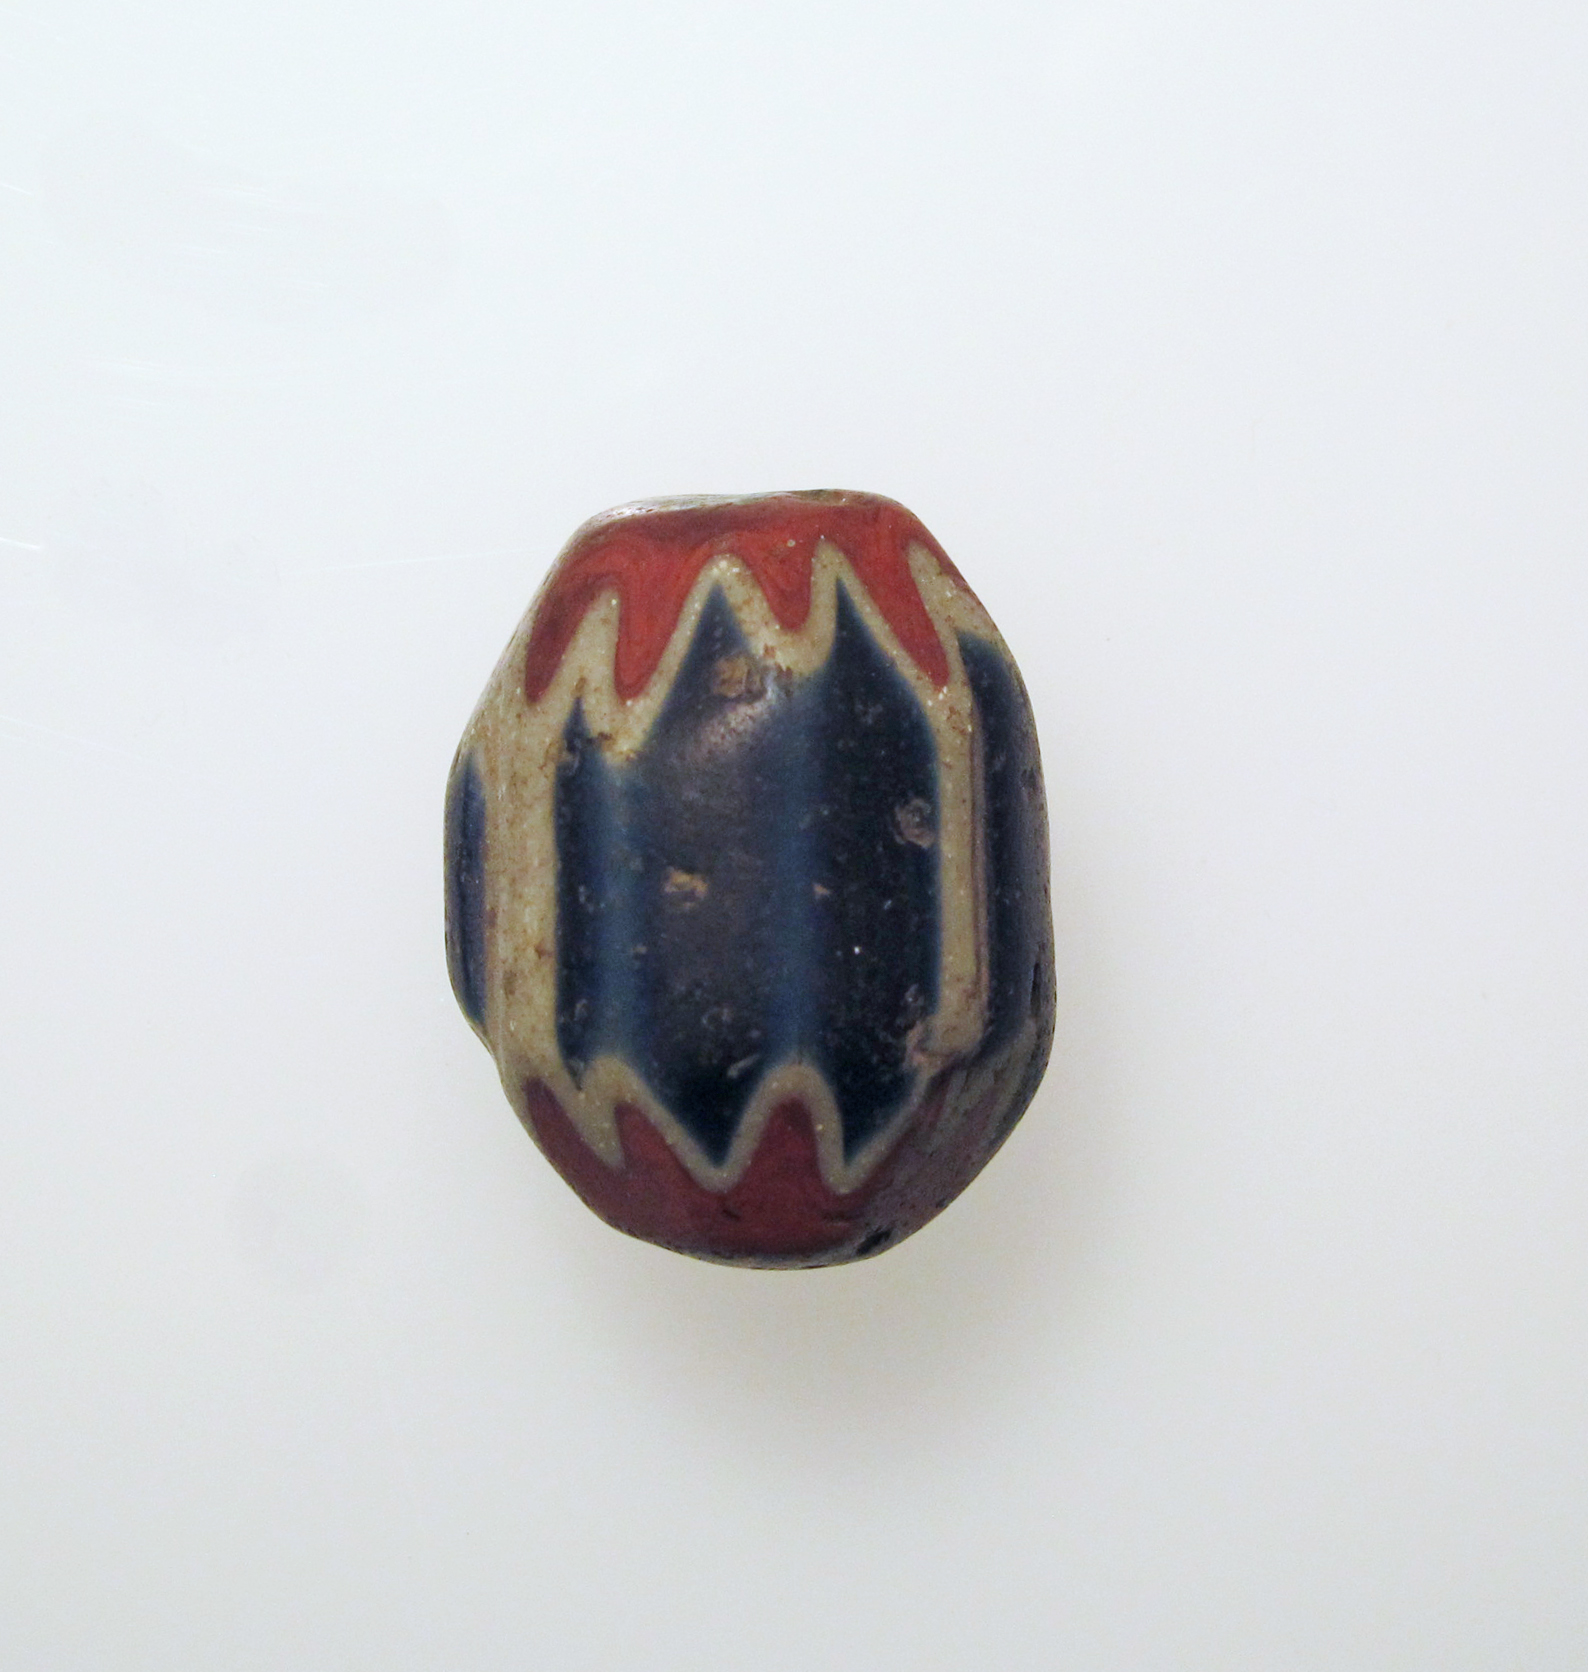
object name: chevron bead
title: Glass chevron bead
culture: venetian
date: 900-100 BCE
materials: glass